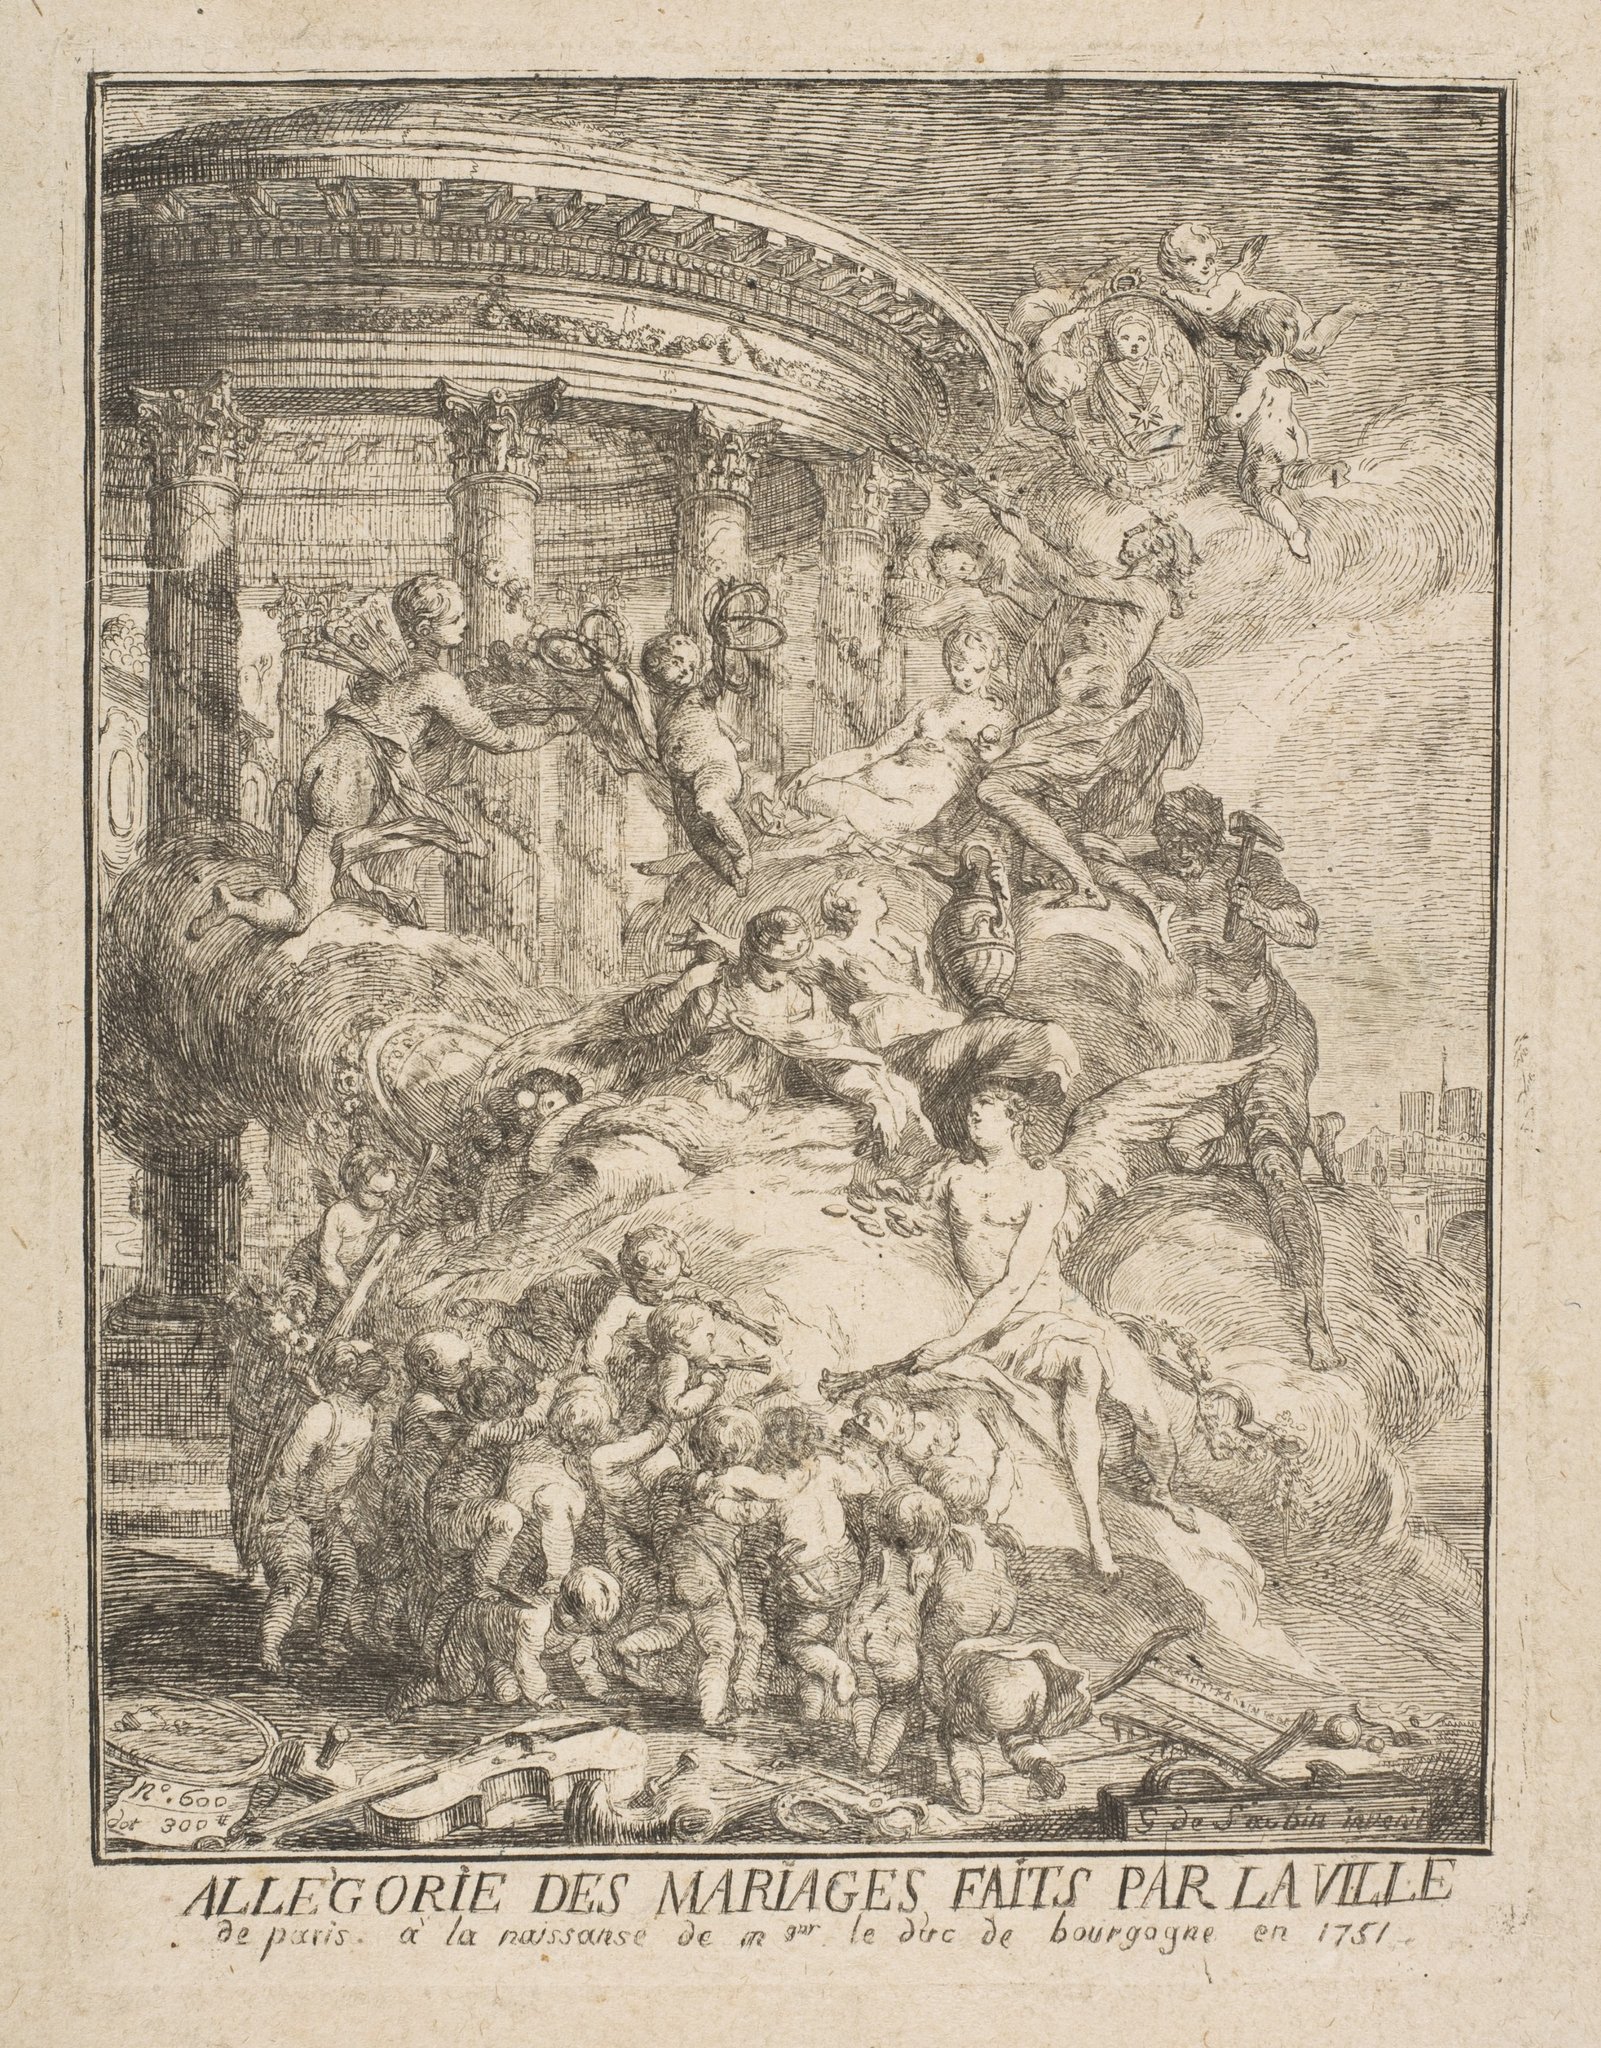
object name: print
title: Allegory of the Marriages Performed by the City of Paris in Honor of the Birth of the Duc de Bourgogne in 1751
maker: gabriel de saint-aubin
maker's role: artist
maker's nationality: french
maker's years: 1724-1780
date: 1752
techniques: etching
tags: musical instruments